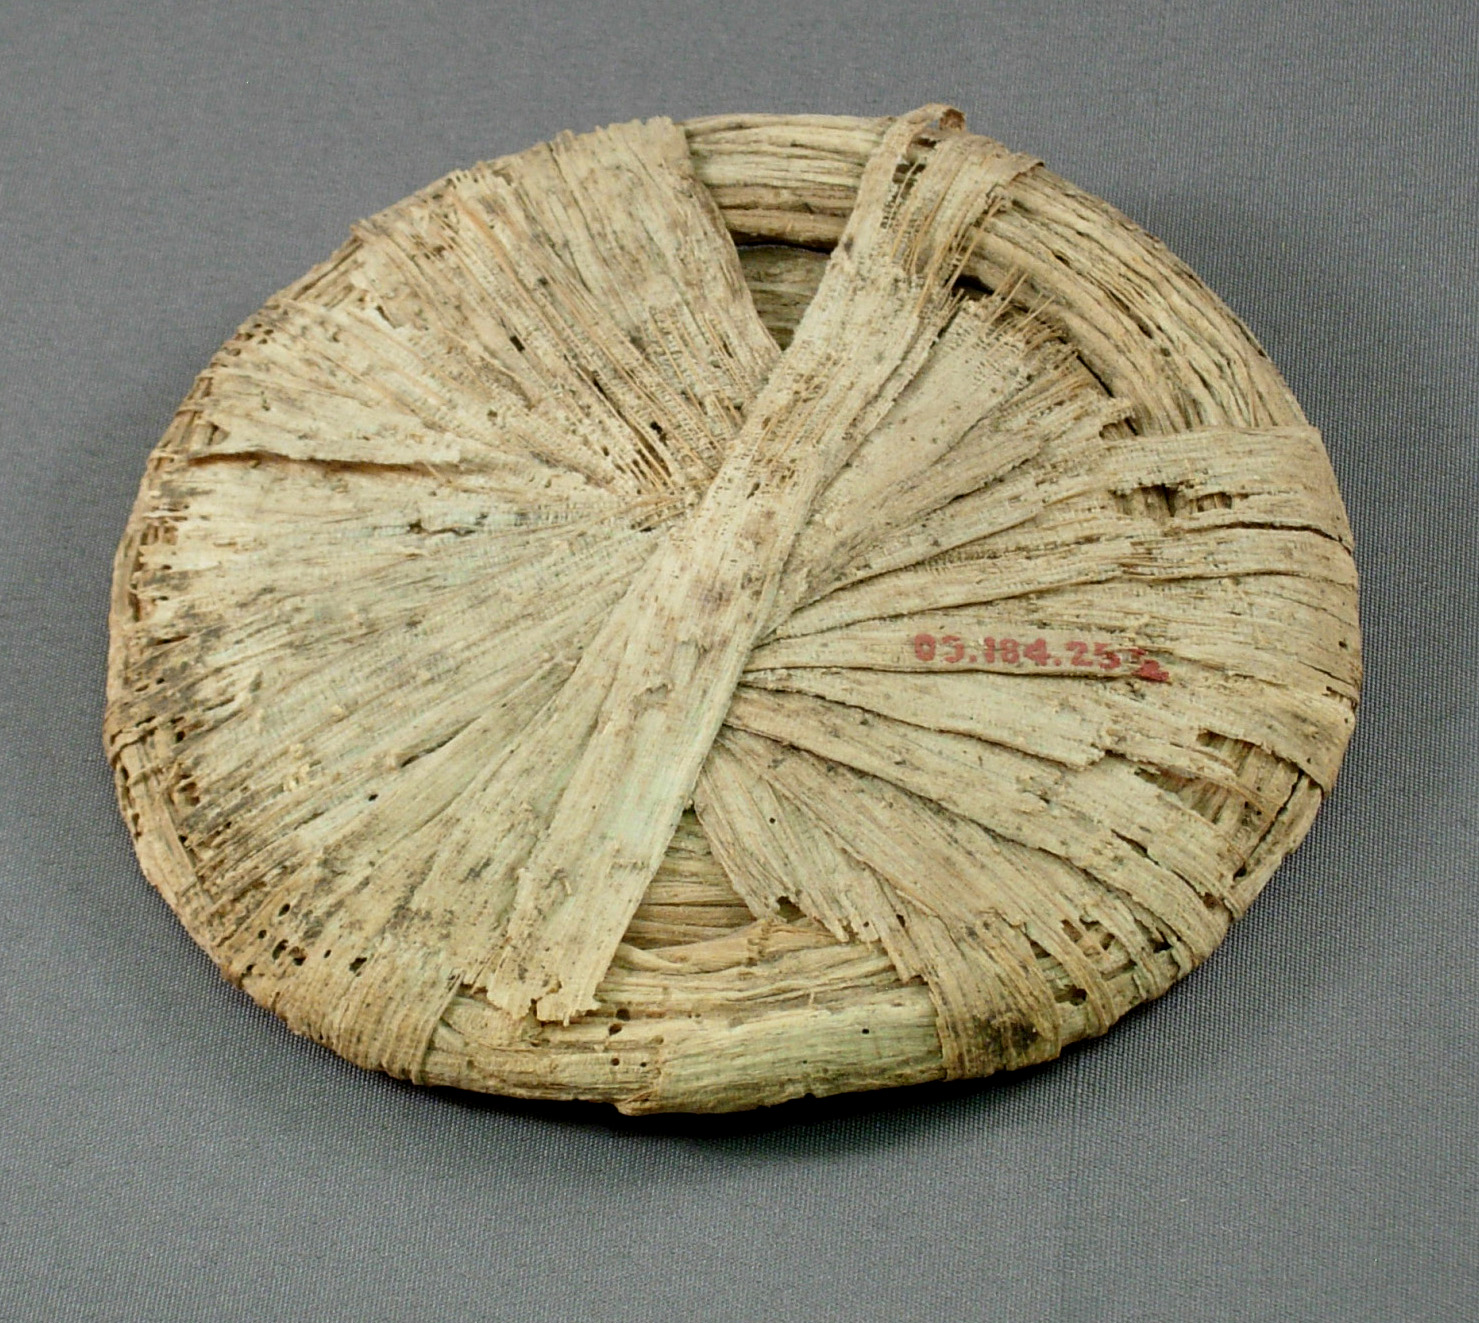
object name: jar lid, papyrus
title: Papyrus Lid from Tutankhamun's Embalming Cache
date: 1336-1327 BCE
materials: papyrus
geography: egypt